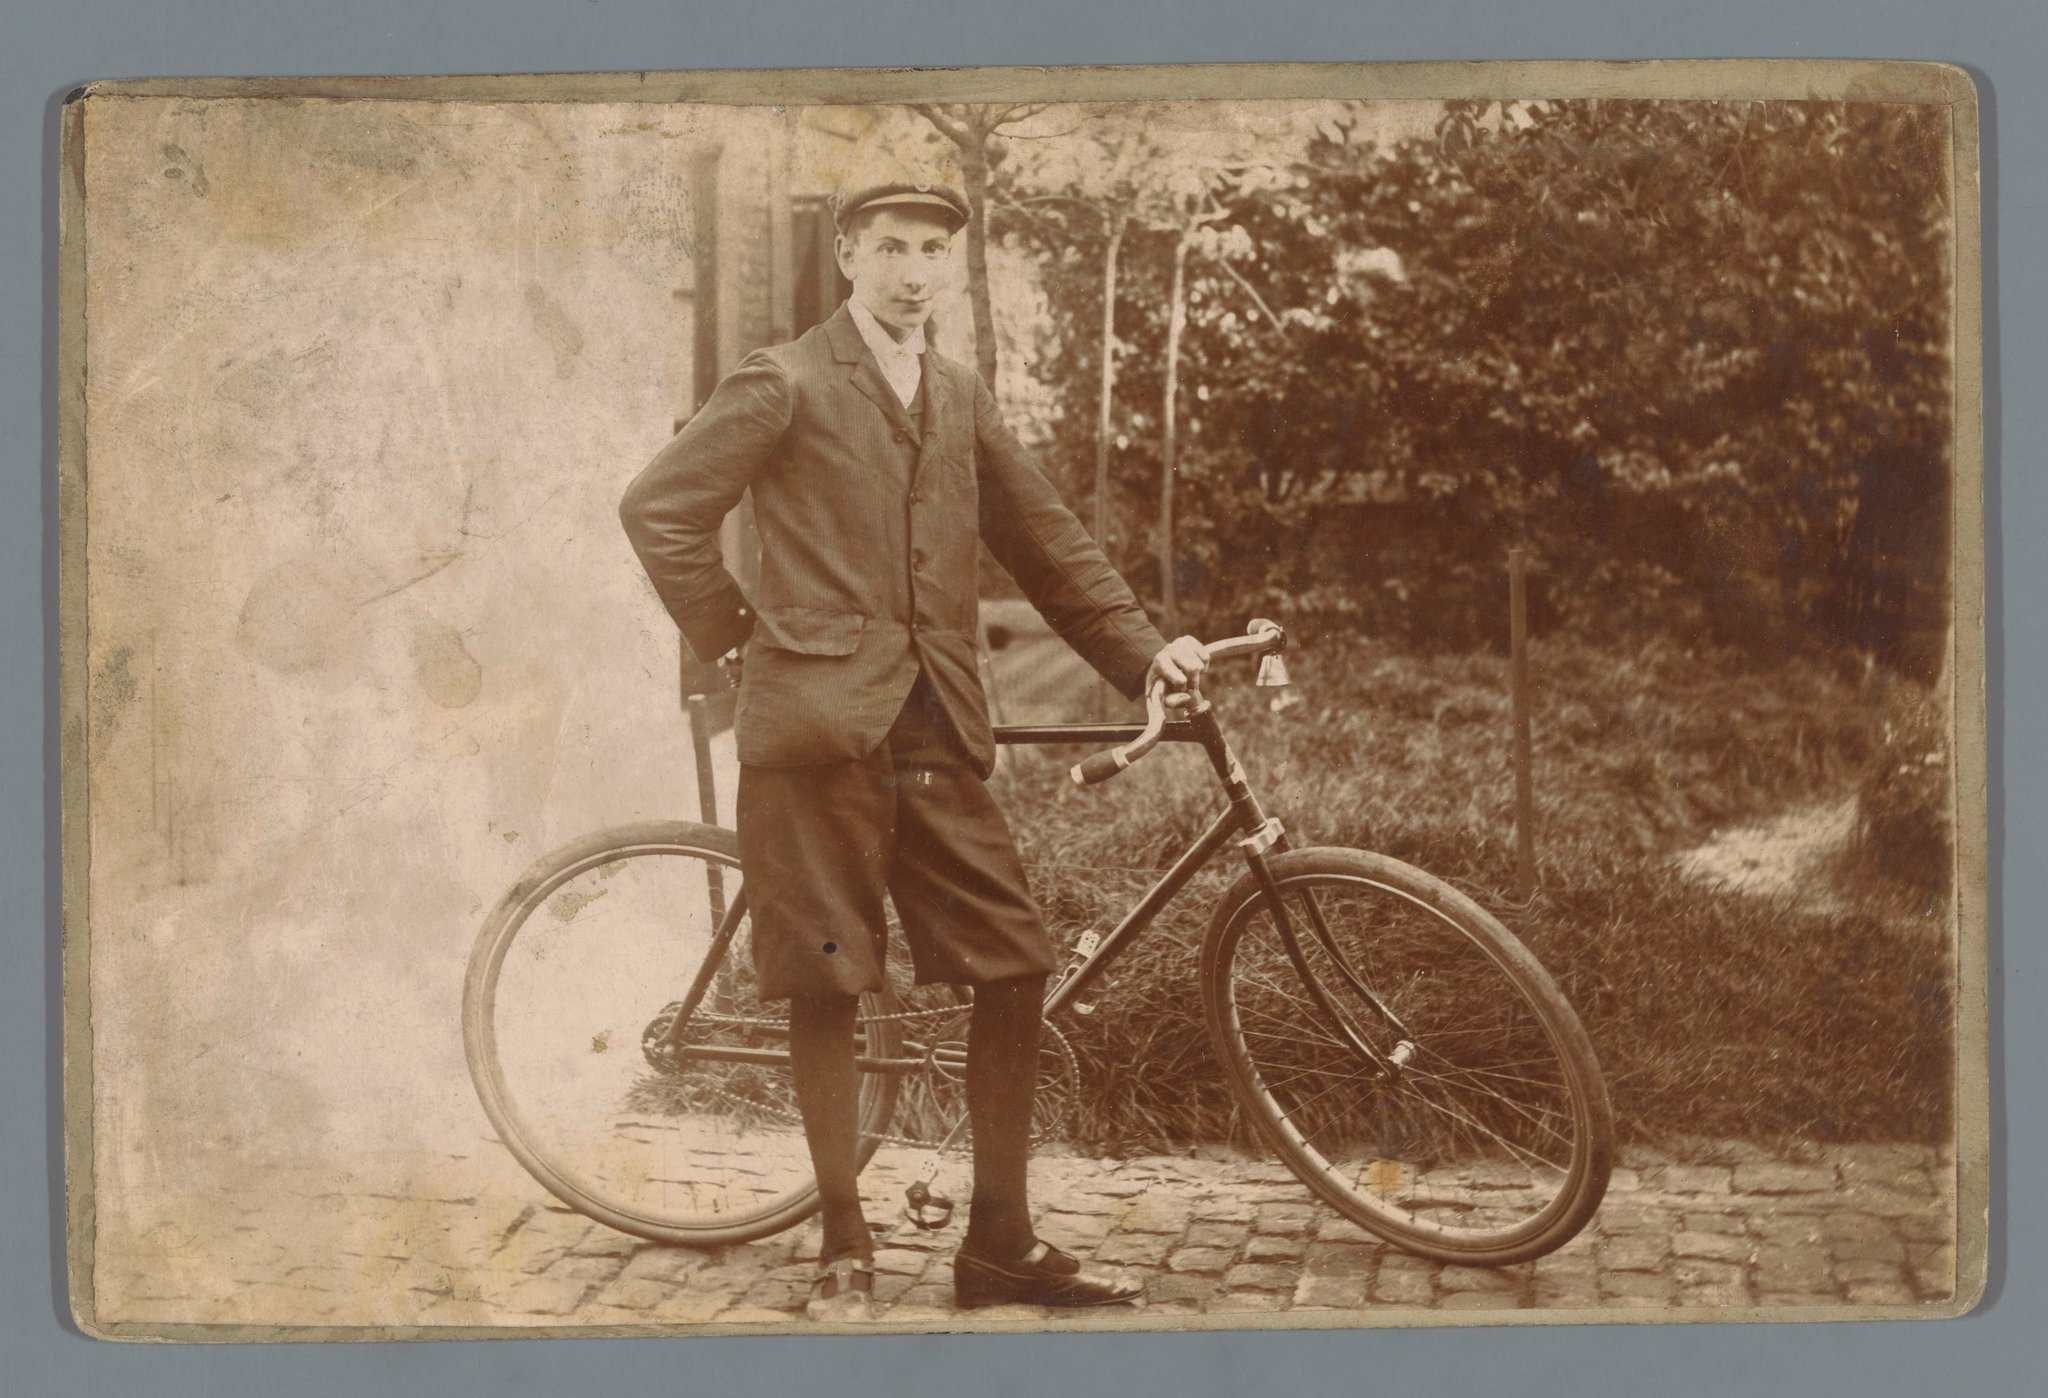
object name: photograph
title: Portret van een onbekende jongen met een fiets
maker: Anonymous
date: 1895-1910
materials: cardboard, photographic support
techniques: gelatin silver print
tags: boy (child between toddler and youth), bicycle